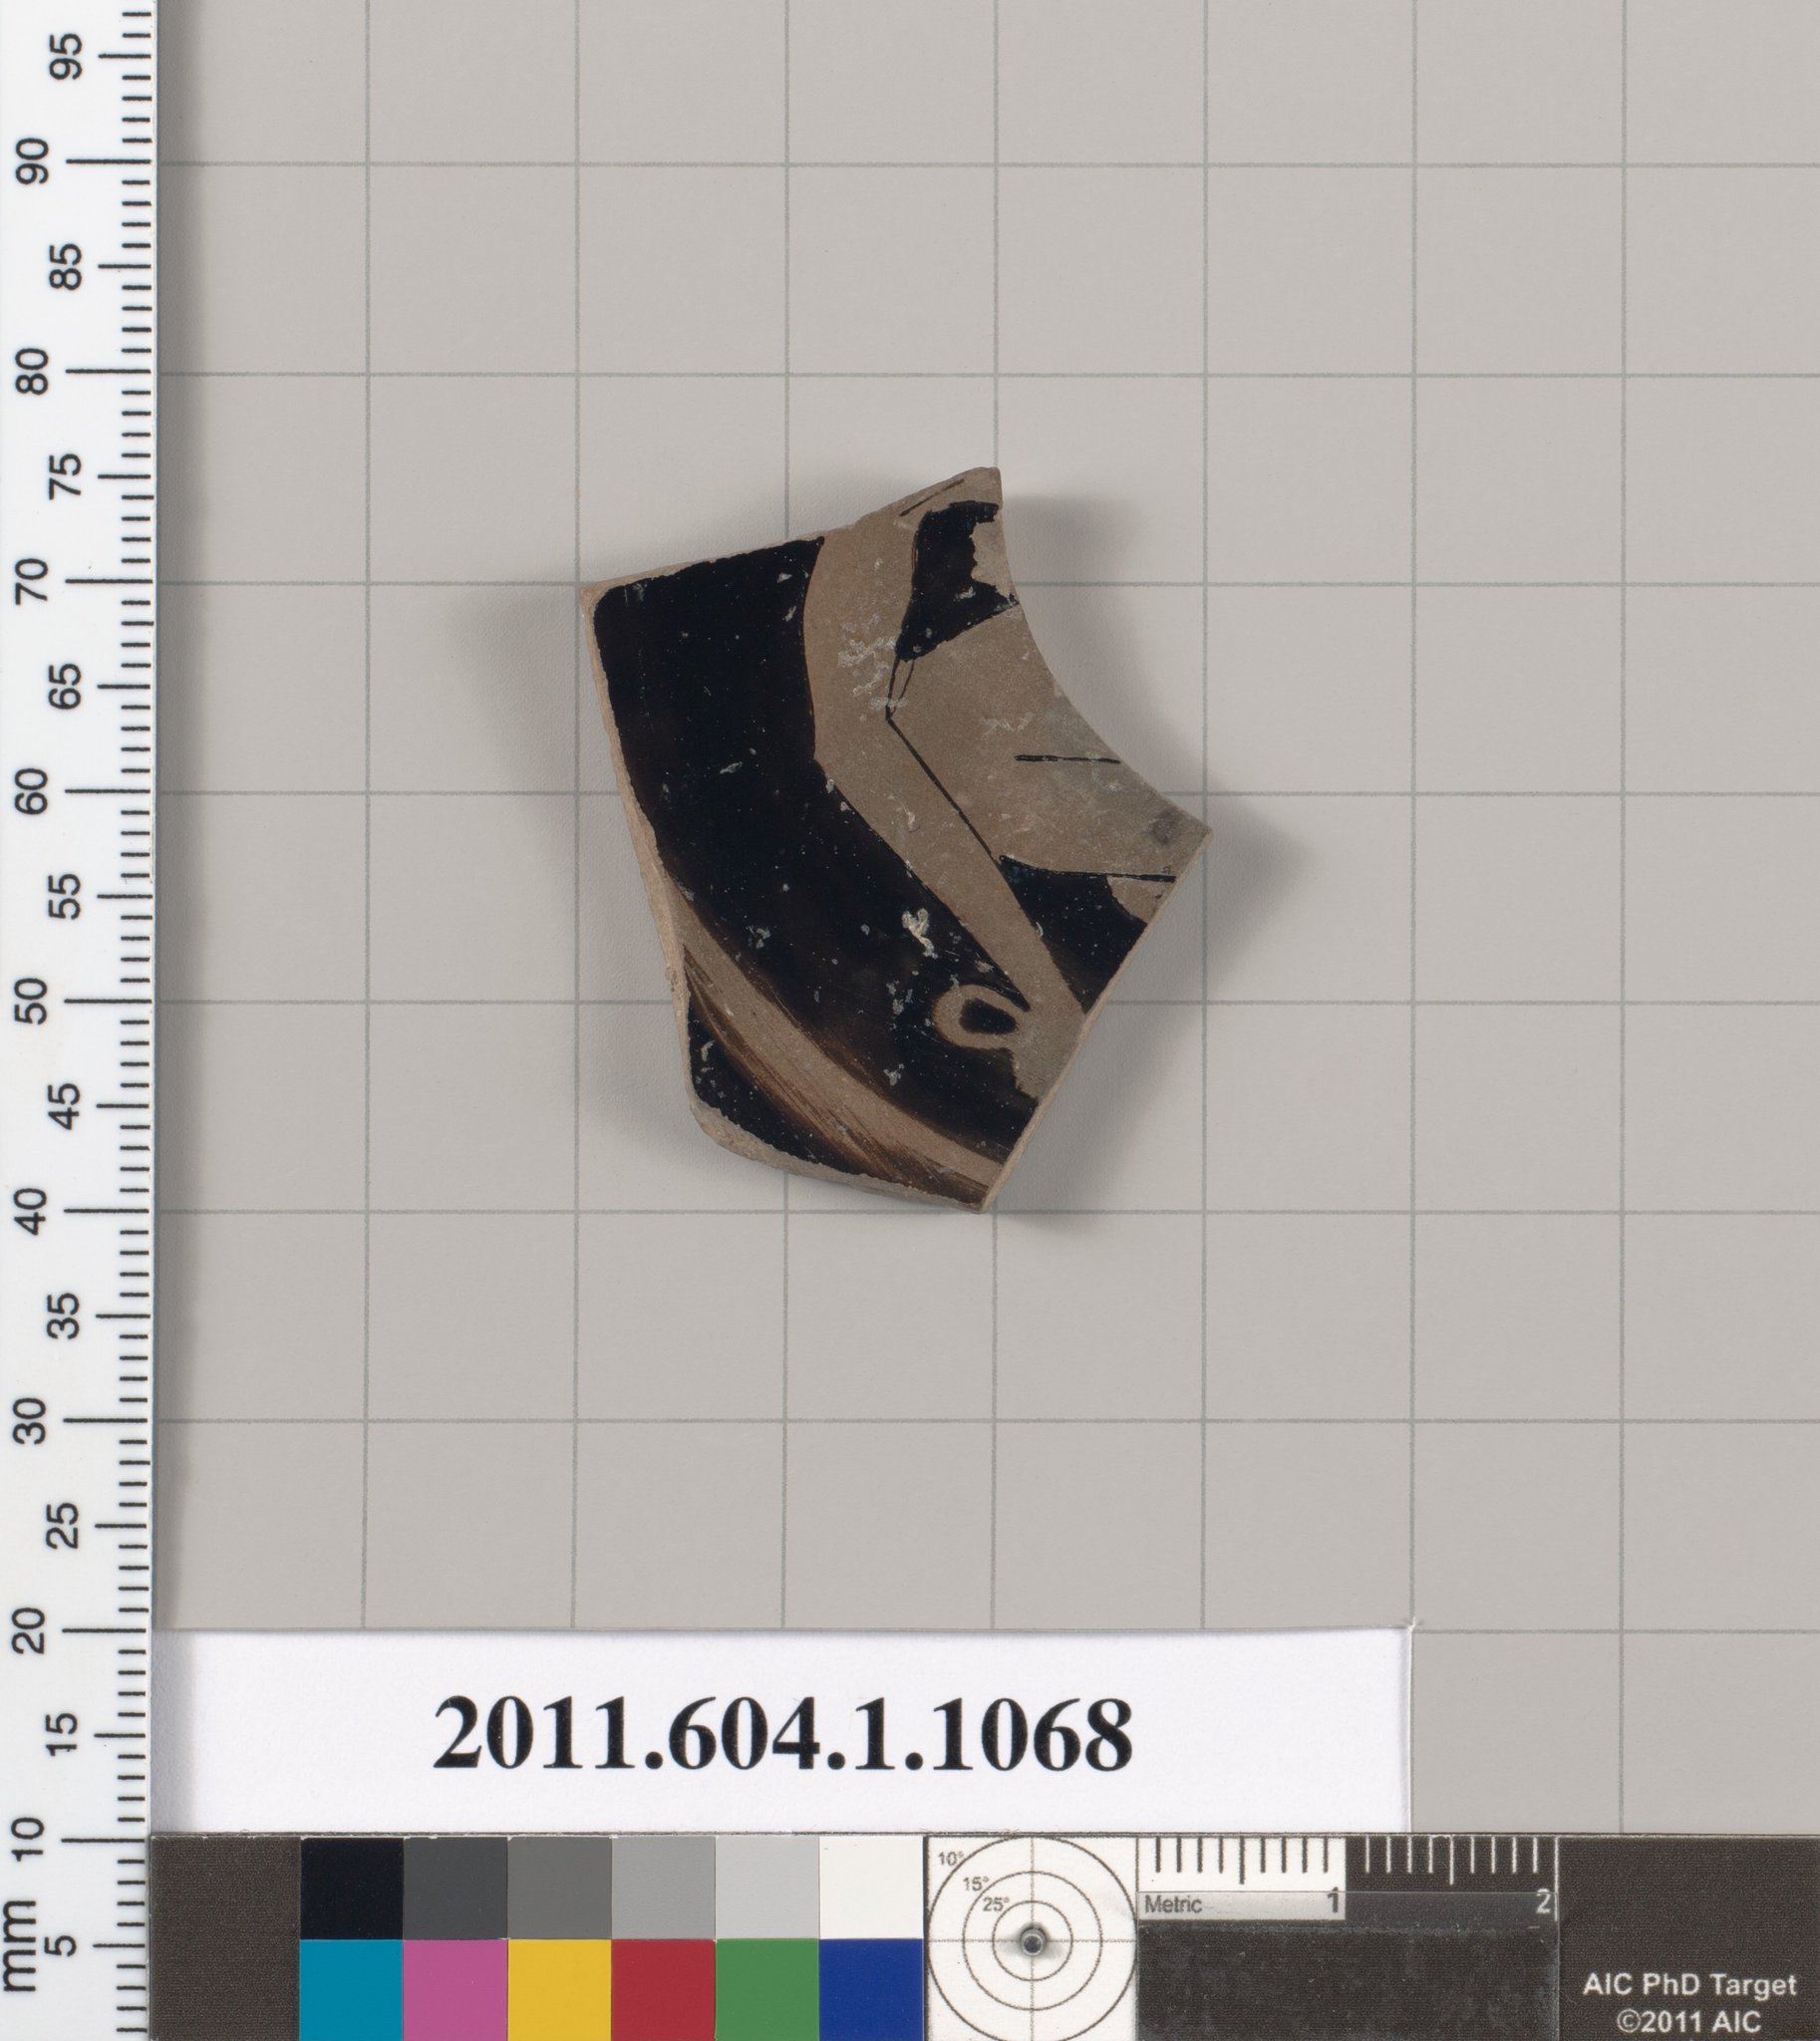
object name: kylix fragment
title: Terracotta fragment of a kylix (drinking cup)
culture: greek, attic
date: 520-500 BCE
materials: terracotta